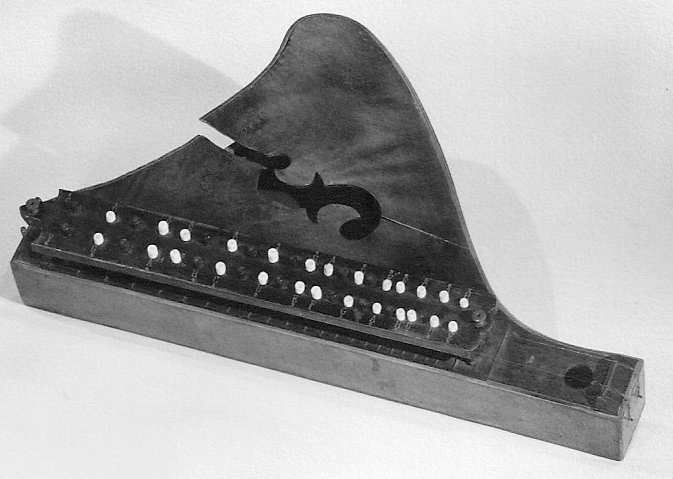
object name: solophon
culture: german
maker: becker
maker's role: maker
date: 1867-1900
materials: metal, wood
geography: germany